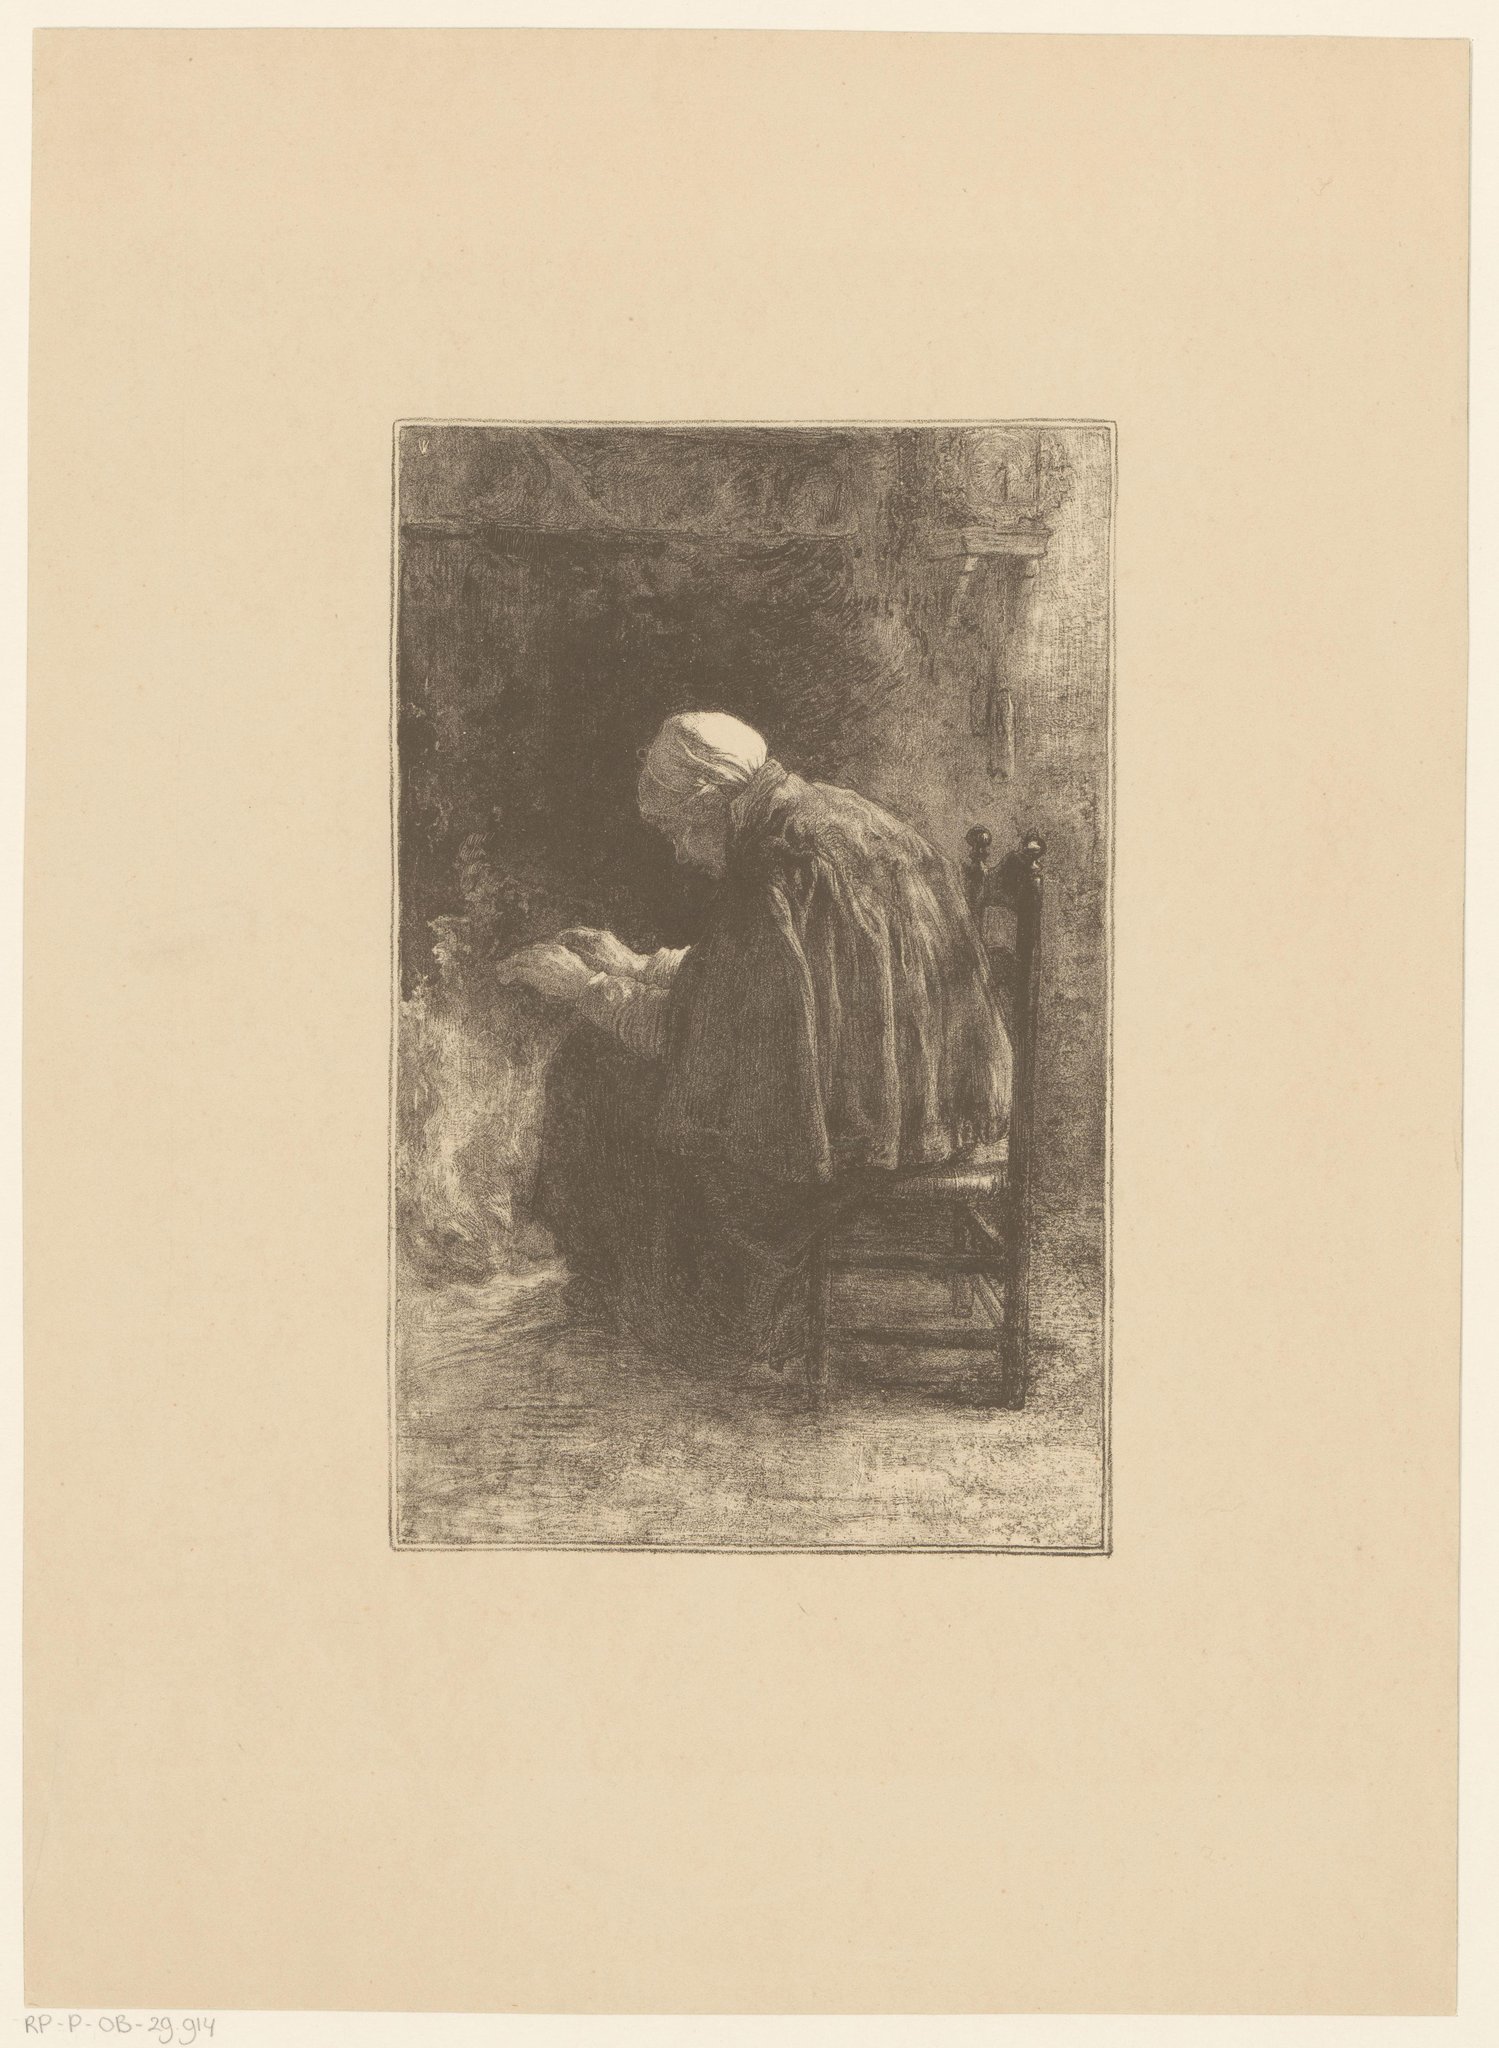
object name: print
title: Oude vrouw bij haard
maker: jan veth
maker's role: designer, draughtsman, painter, print maker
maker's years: 1864-1925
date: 1883-1925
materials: paper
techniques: lithograph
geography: netherlands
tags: warming oneself at a fire (or hearth, stove, fire-pan, brazier)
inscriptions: collector's mark: Lugt 2228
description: Oude vrouw, zittend op stoel, haar handen warmend aan de haard. Rechts naast haar een krukje met kom erop. Links aan de muur hangt een wandklok.